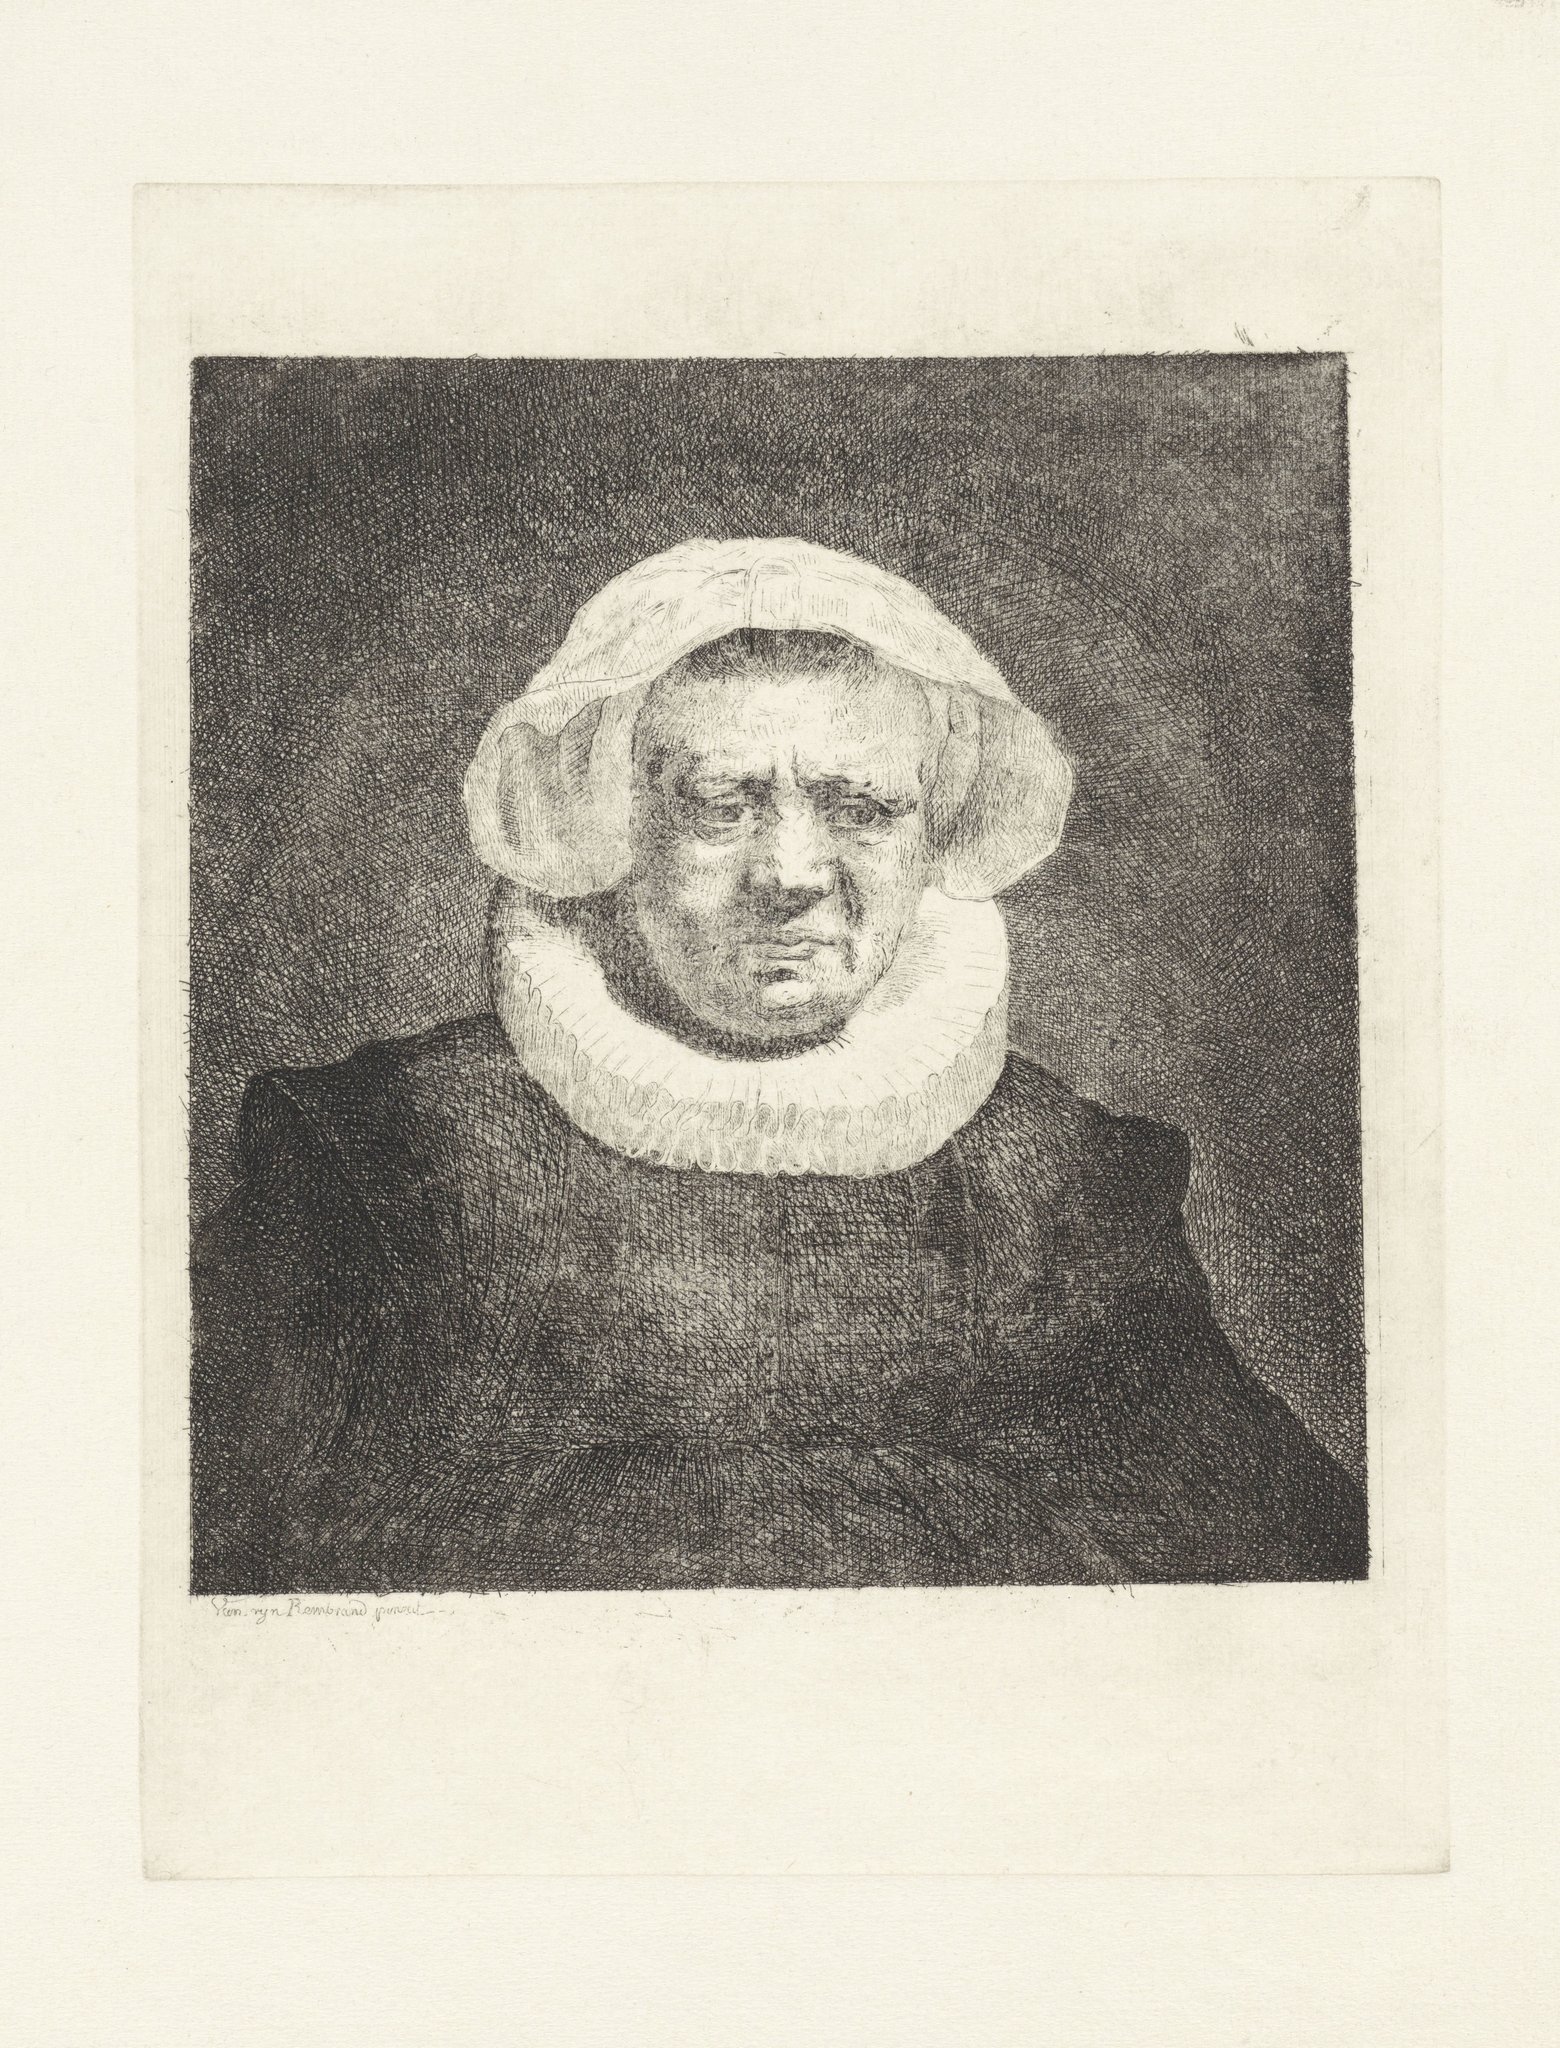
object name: print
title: Portret van Aechje Claesdr.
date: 1634-1719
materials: paper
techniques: etching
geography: northern netherlands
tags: historical persons - bb - woman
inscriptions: collector's mark: Lugt 2228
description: Buste van Aechje Claesdr, weduwe van de Rotterdamse brouwer Jan Dammaszn. Pesser.